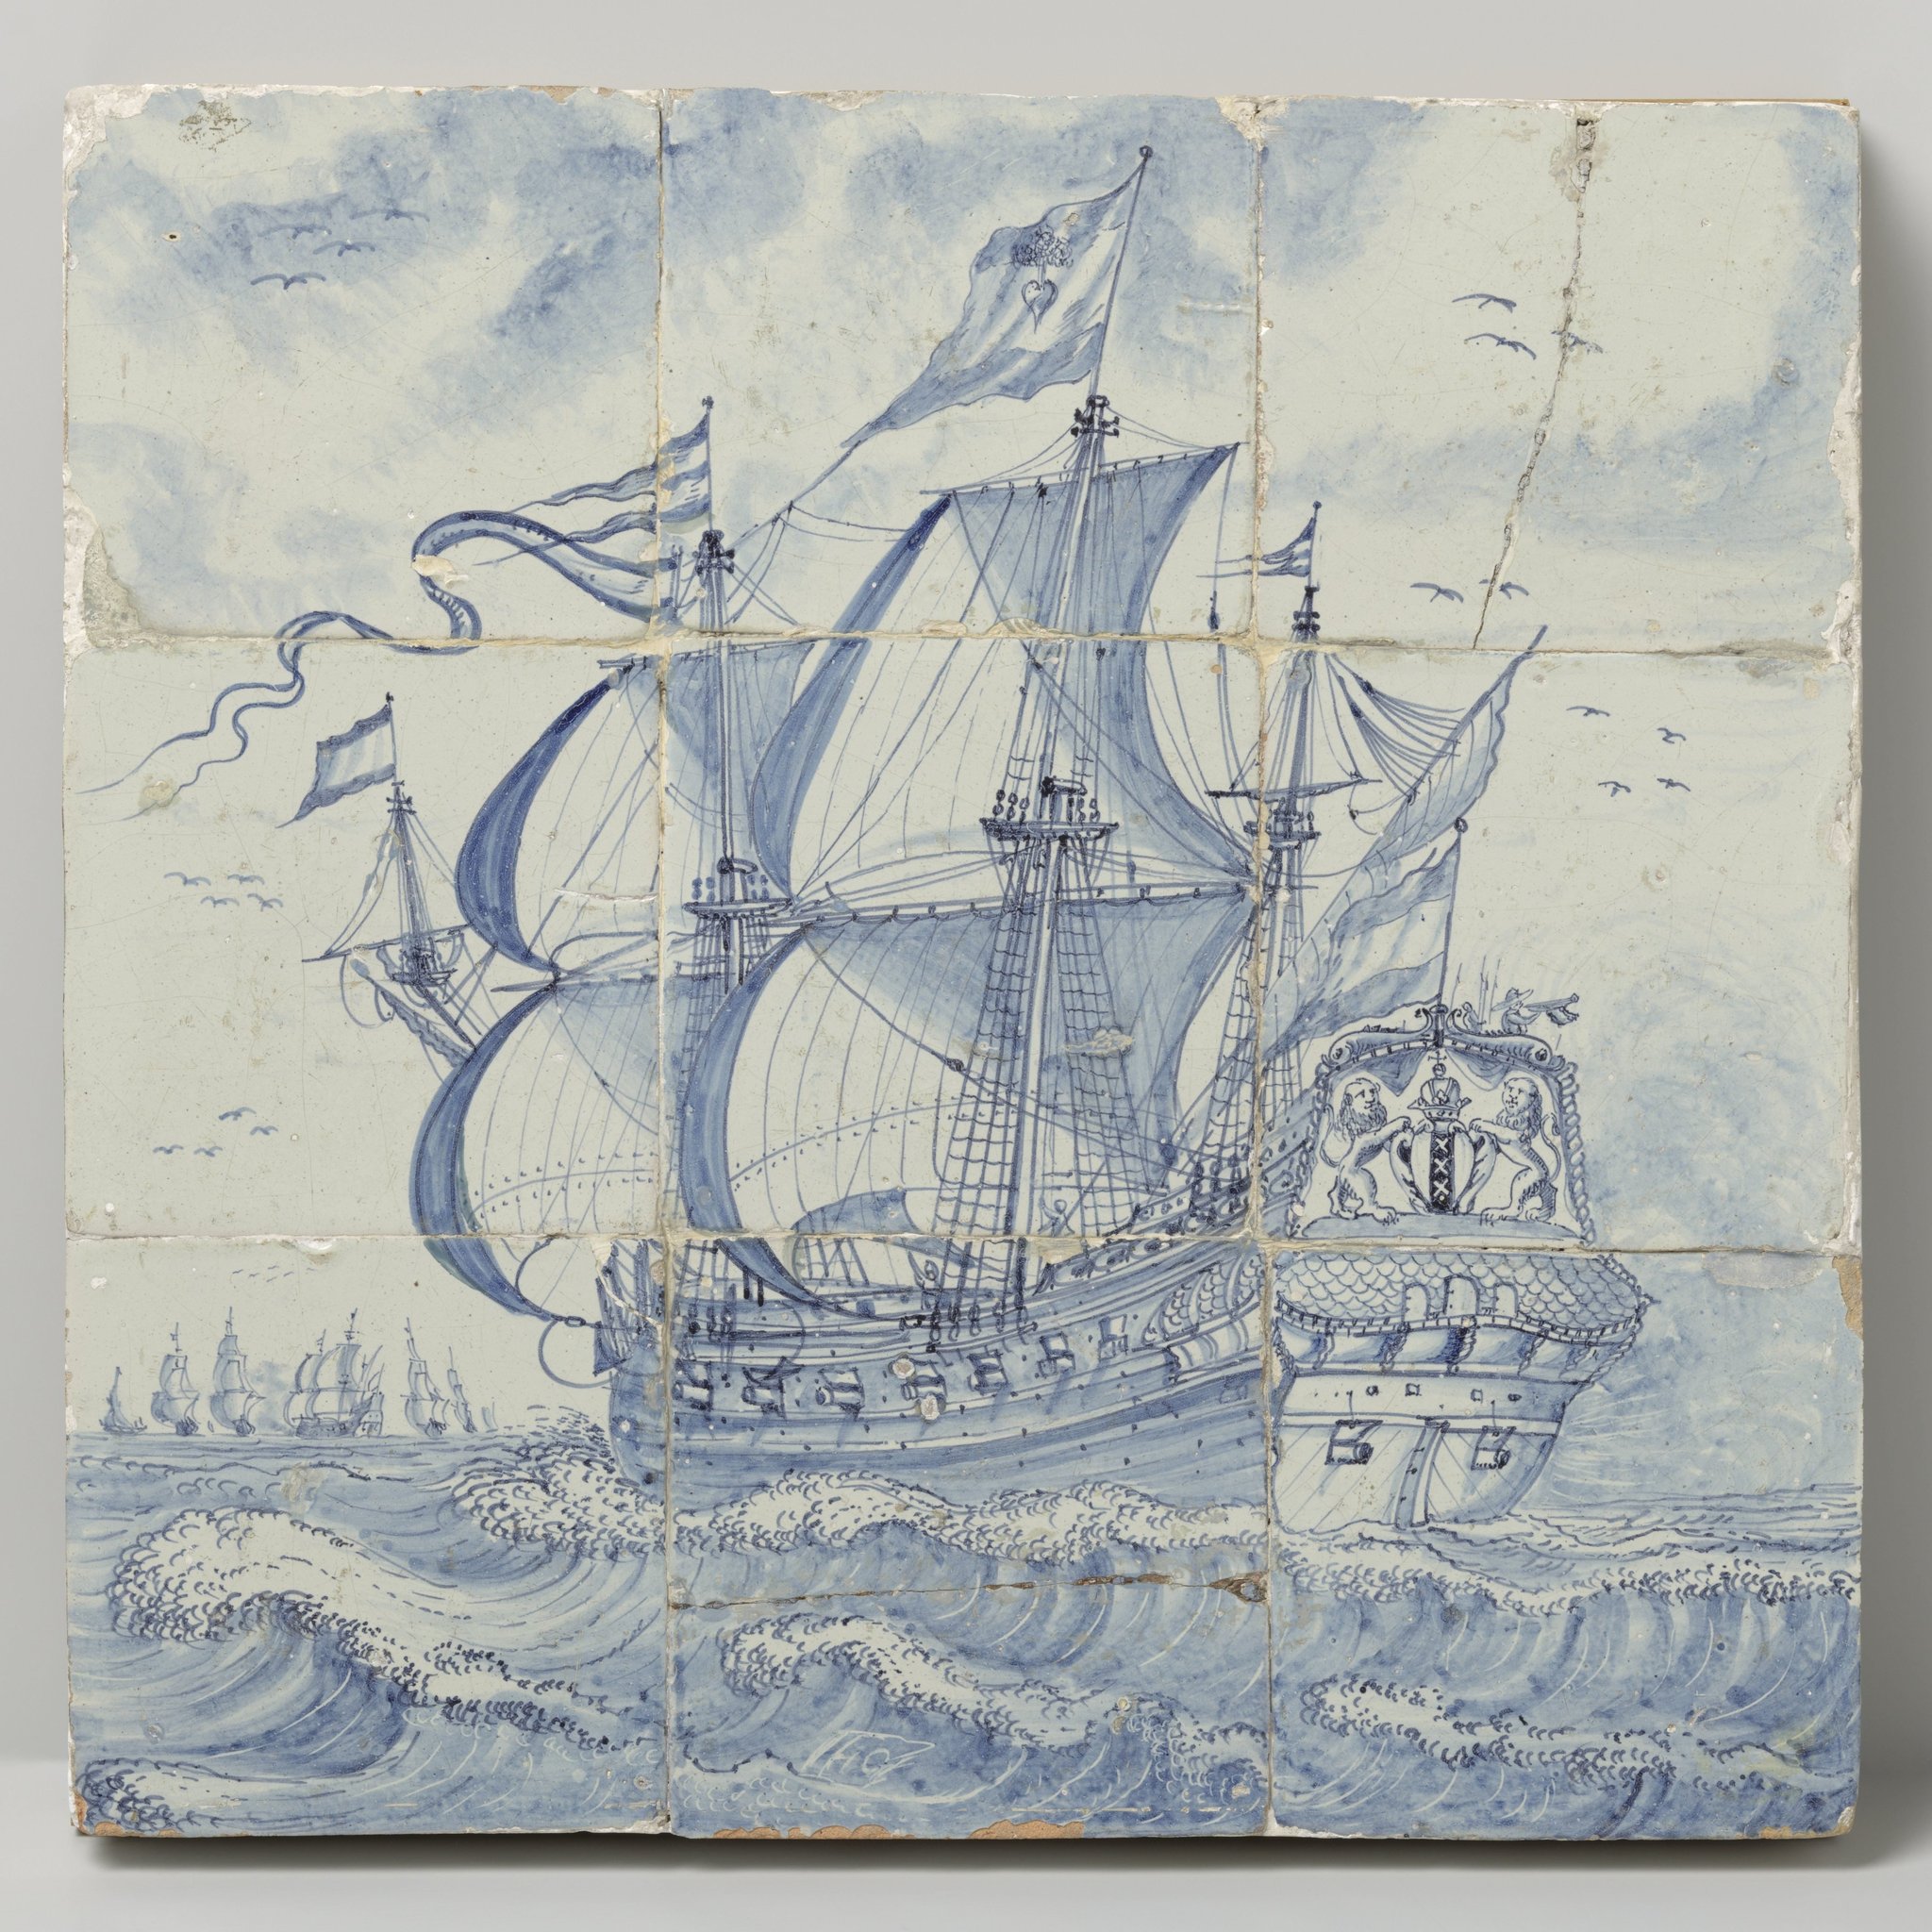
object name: tile tableau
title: Tegeltableau van negen tegels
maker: Anonymous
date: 1880-1900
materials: earthenware, glaze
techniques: maiolica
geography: netherlands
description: Tegeltableau van 9 tegels (3 x 3) met een blauw geschilderd zeilschip met het wapen van Amsterdam op de achterkant.